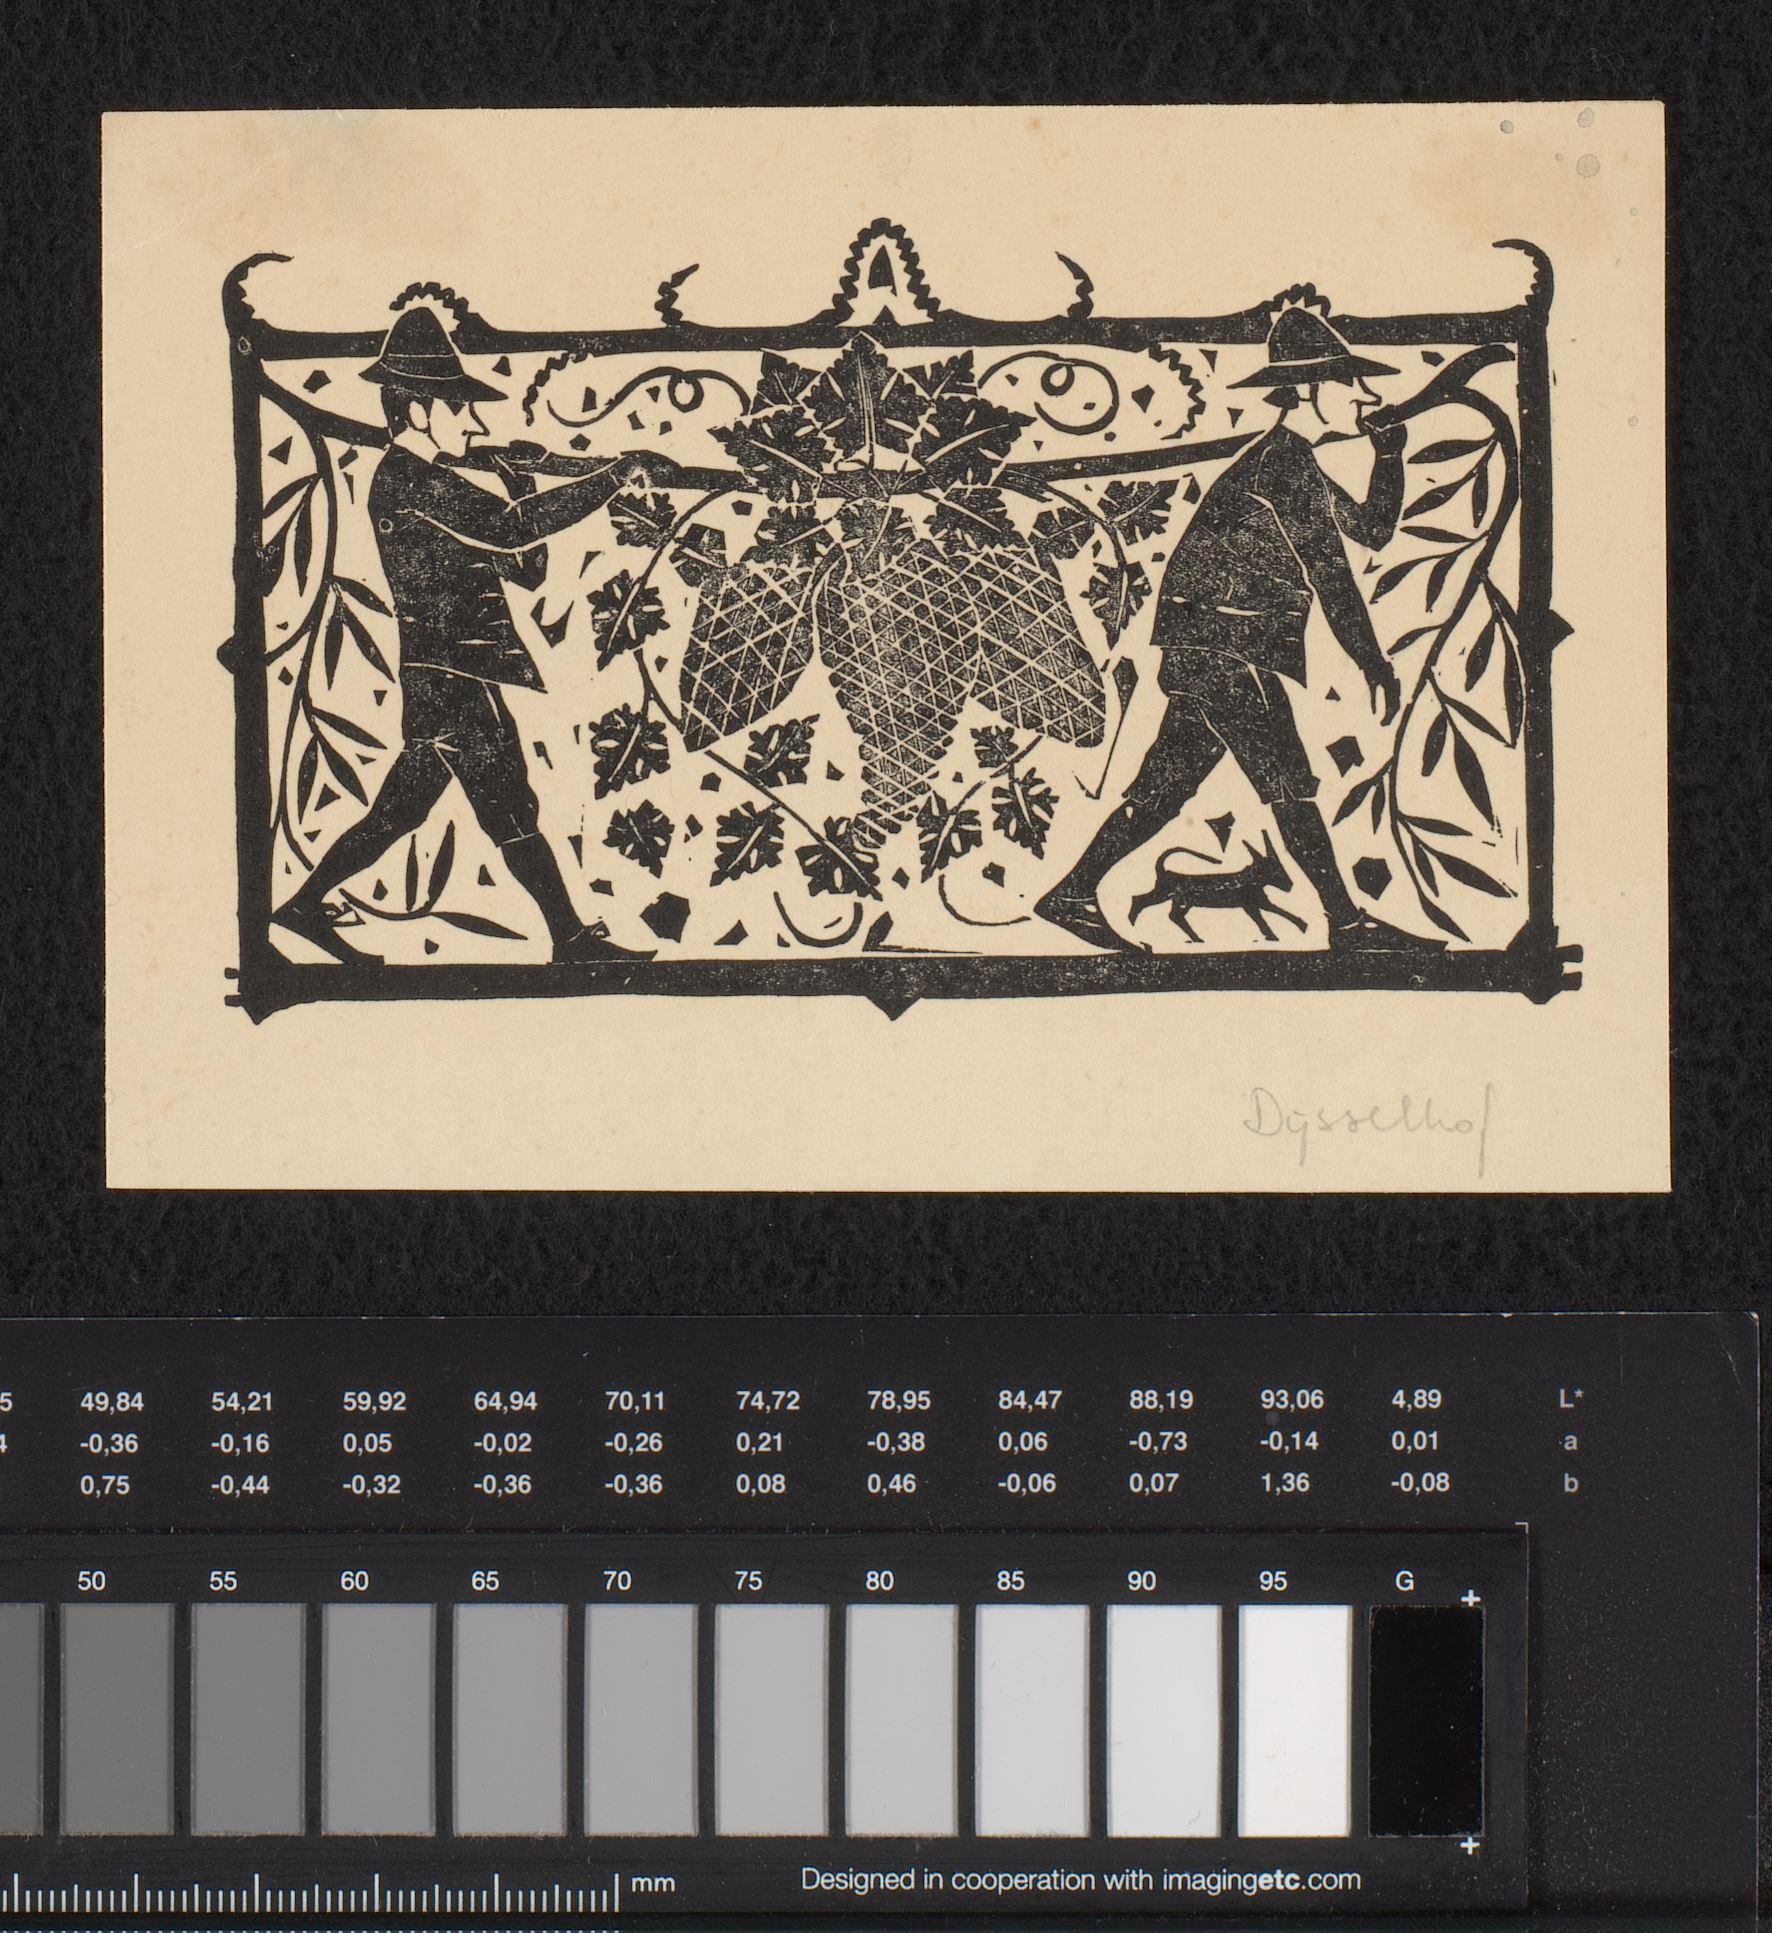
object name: book illustration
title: Titelhoofd met mannen die druiventrossen dragen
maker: gerrit willem dijsselhof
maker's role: designer, draughtsman, print maker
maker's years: 1866-1924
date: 1893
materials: paper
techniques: galvanoplasty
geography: amsterdam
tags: flowers ~ ornament - aa - stylized, bunch of grapes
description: Titelhoofd uit: Crane, Walter. Kunst en samenleving. [Vertaald uit het Engels door] Jan Veth. Amsterdam: Scheltema & Holkema's Boekhandel, 1894 [1893], p. 50. Later zijn deze afbeeldingen door de uitgever veelvuldig gebruikt voor andere uitgaven. Zie bijvoorbeeld RP-P-1969-415, een catalogus van de in 1894 bij Scheltema & Holkema's Boekhandel verkrijgbare publicaties.